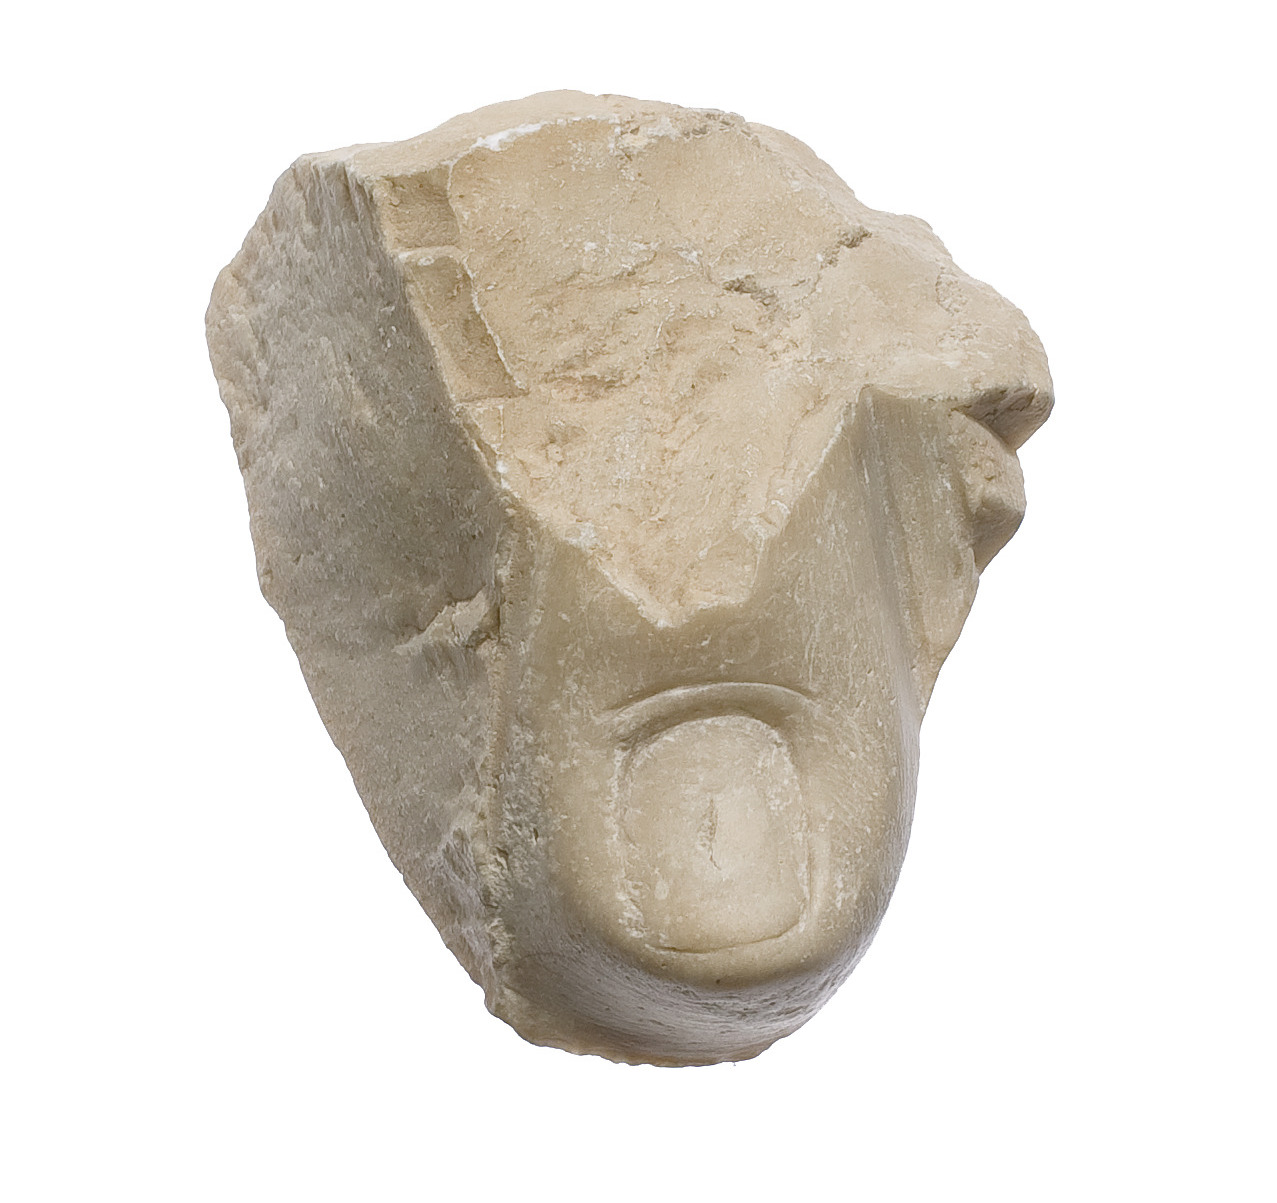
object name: akhenaten or nefertiti big toe of prostrate foot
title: Toe of prostrate foot (?) of Akhenaten or Nefertiti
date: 1352-1336 BCE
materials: limestone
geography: egypt